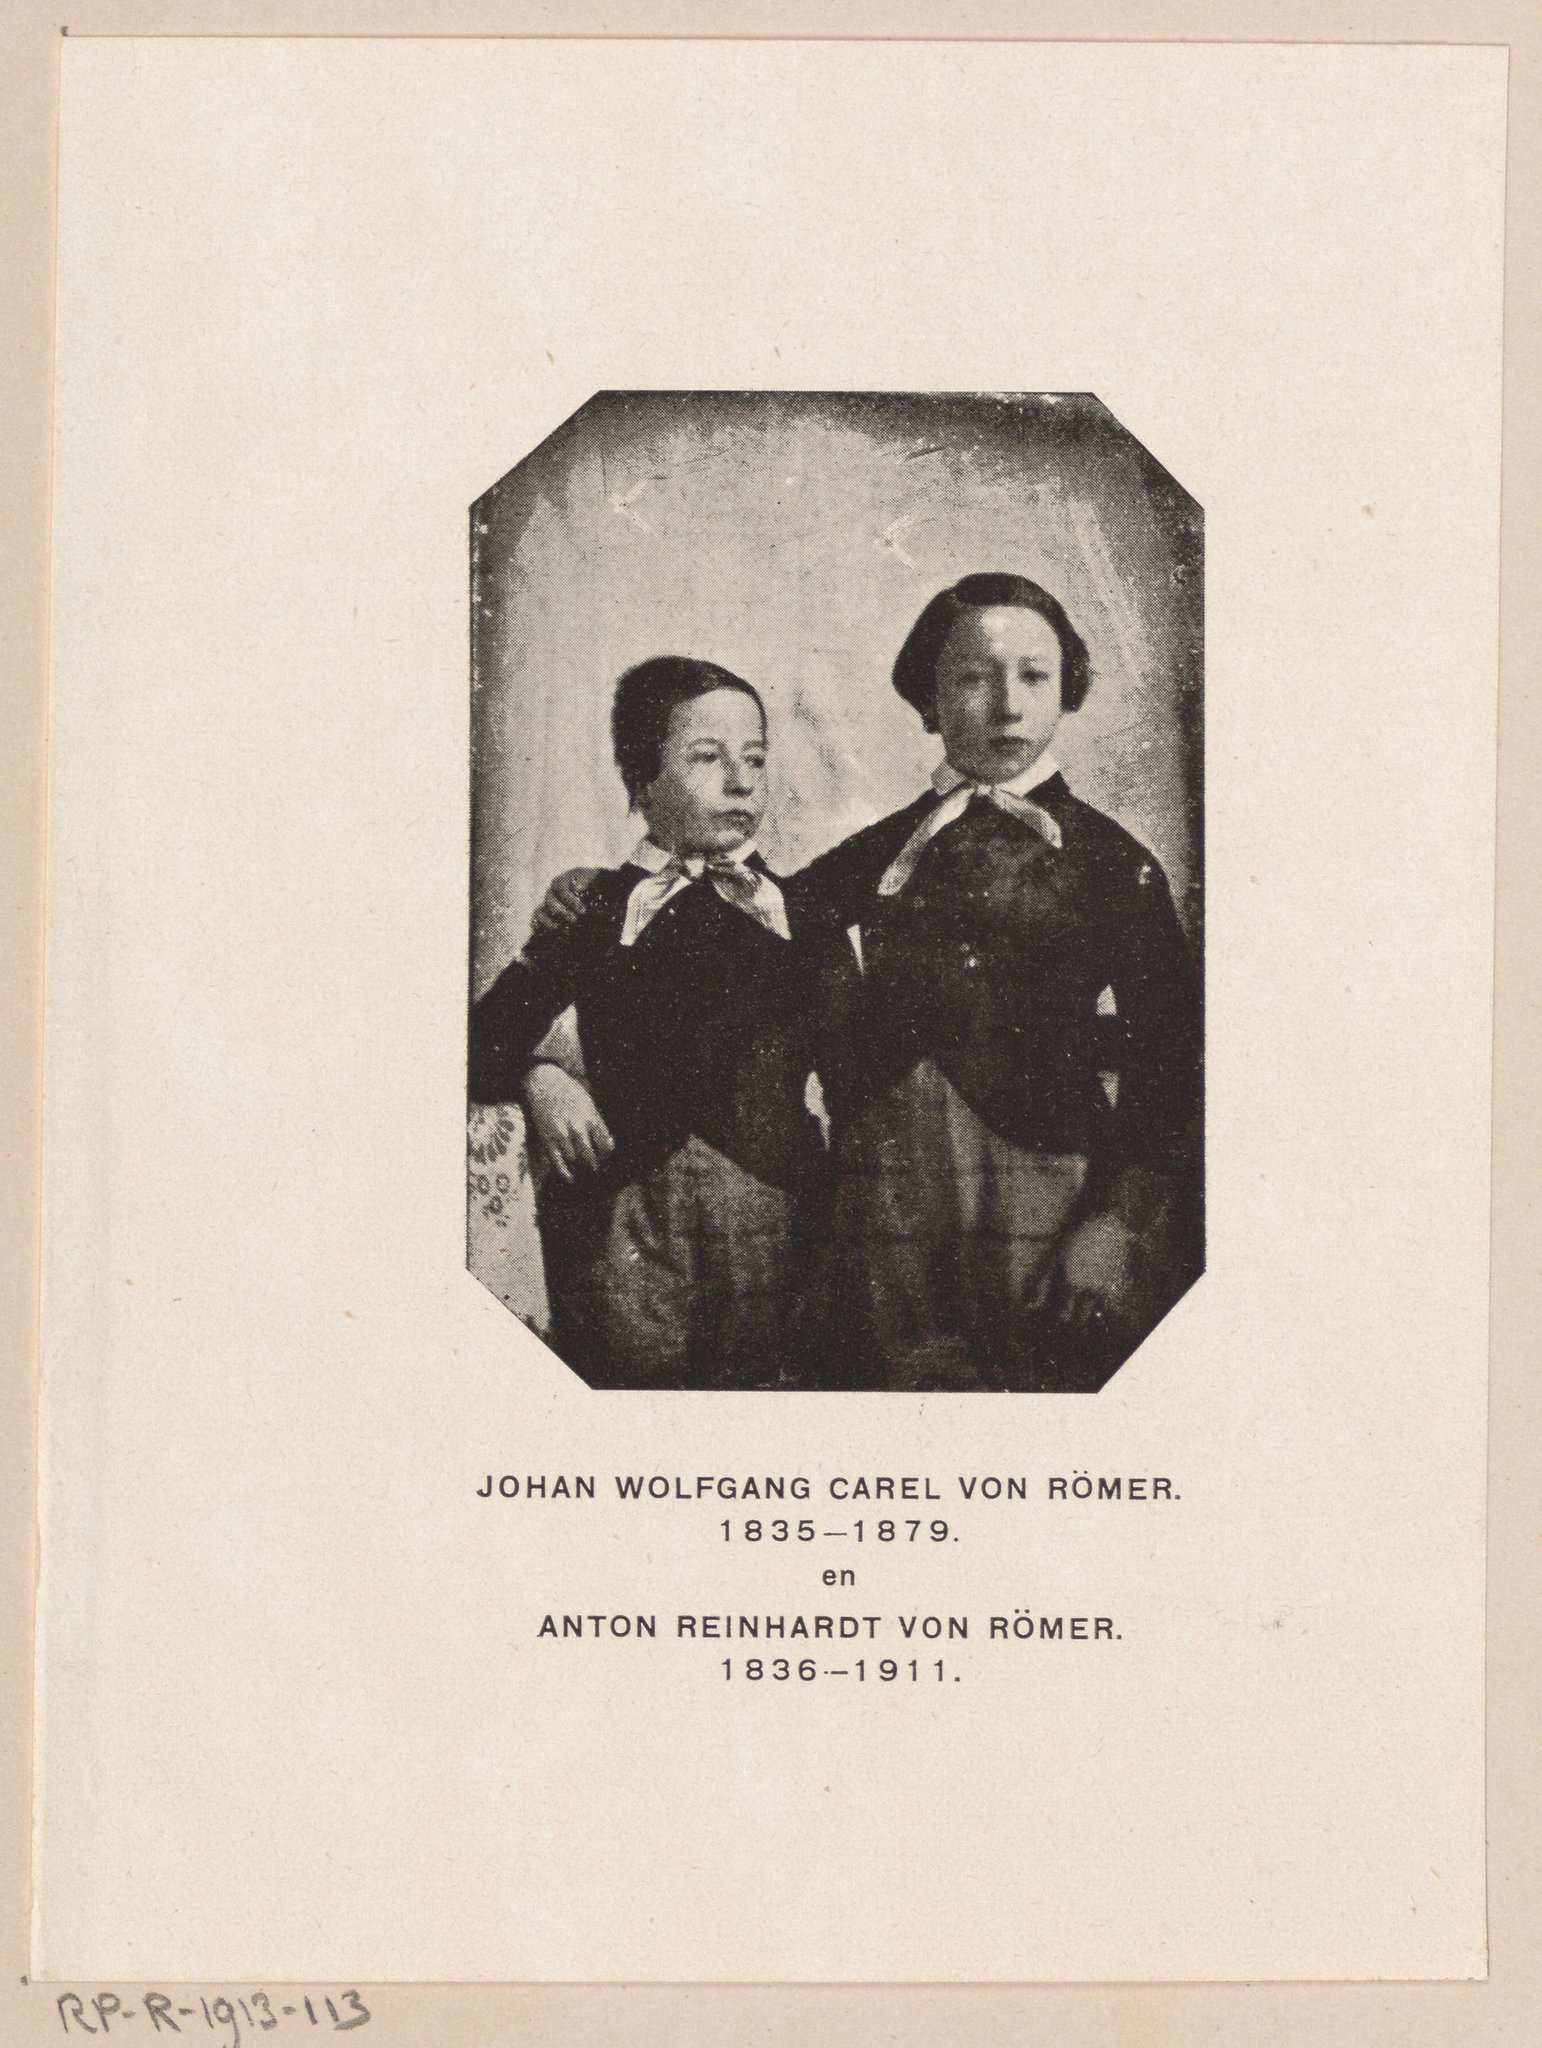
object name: photomechanical print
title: Portret van Johan Wolfgang Carel von Römer en Anton Reinhardt von Römer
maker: Anonymous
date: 1913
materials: paper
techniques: letterpress printing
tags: historical persons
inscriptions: collector's mark: Lugt 2228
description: Prent mogelijk uit: Nederland's Patriciaat, 1913.